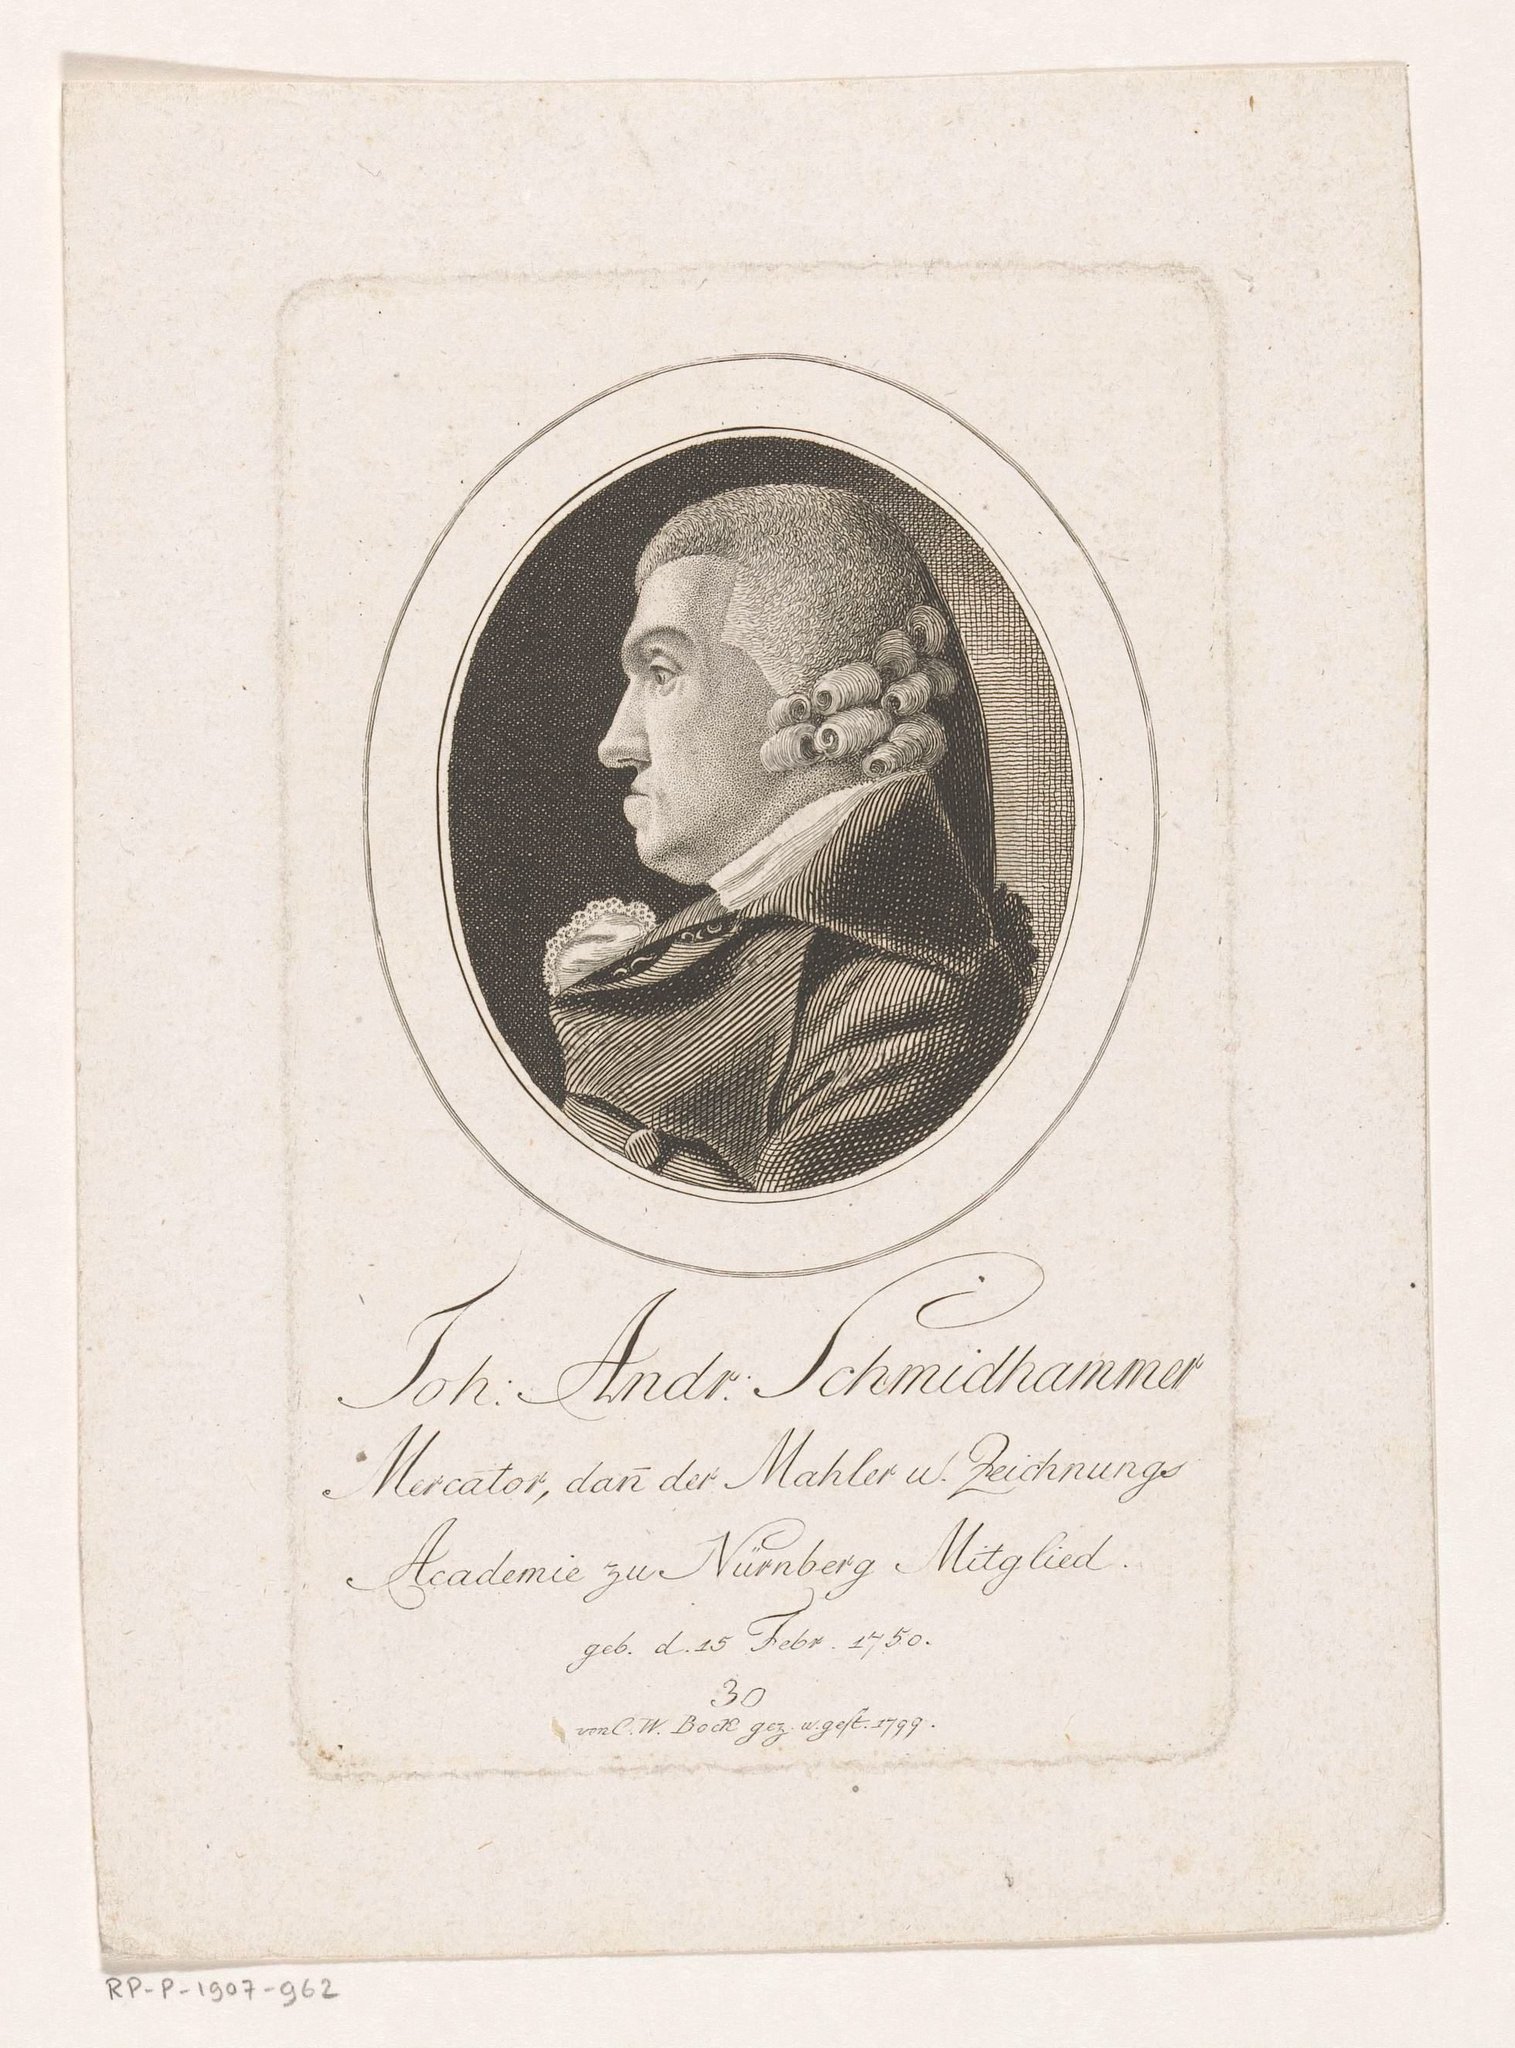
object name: print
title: Portret van Johann Andreas Schmidhammer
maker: christoph wilhelm bock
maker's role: print maker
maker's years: 1755-1836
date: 1765-1836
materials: paper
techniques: engraving, etching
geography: nuremberg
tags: historical persons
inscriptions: collector's mark: Lugt 2228